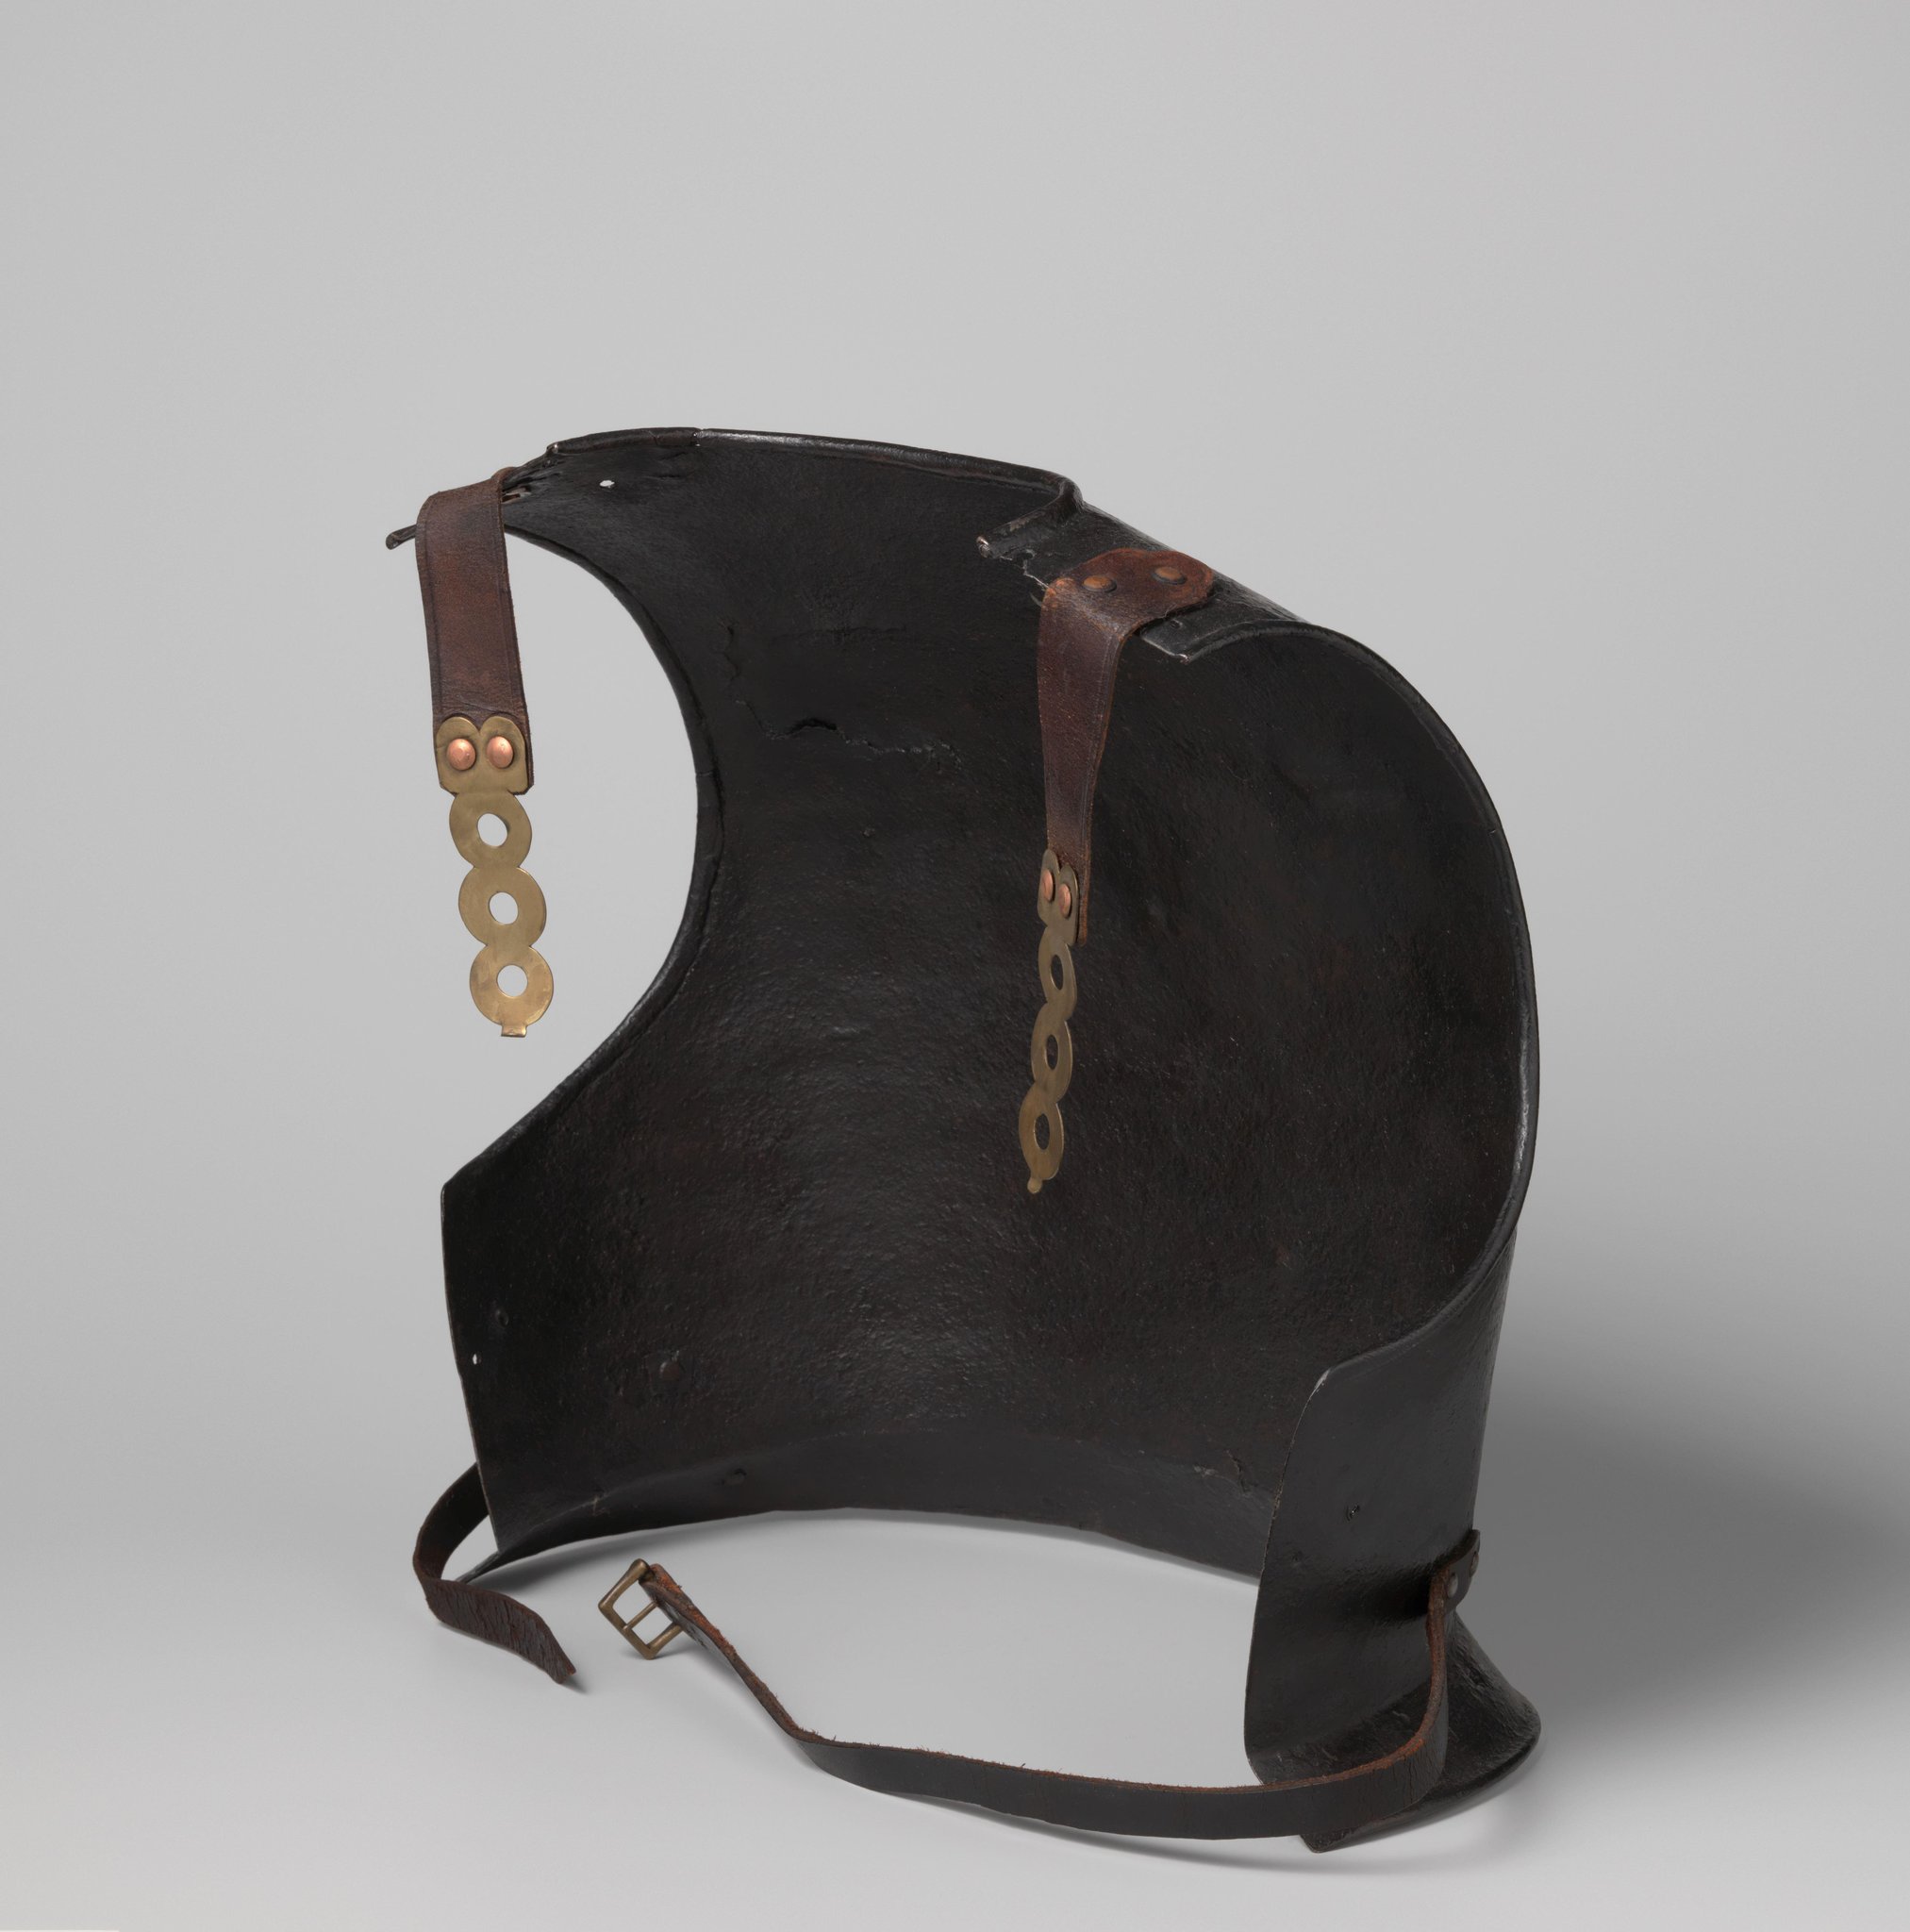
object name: backplate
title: Rugplaat van ijzeren kuras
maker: Anonymous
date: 1600-1699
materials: copper, iron, leather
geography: netherlands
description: Rugplaat, ijzer, zwart geverfd, uit één plaat gemaakt. Randen van nek- en armuitsnijdingen rondgeflenst. Aan weerzijden van de armuitsnijdingen twee aangeklonken schouderriemen, onderaan, direct boven de lendenstrook aangeklonken stoot- en gespriem van de middelriem. De driedubbele decoratielijn lopen parallel aan de randen van de rugplaat. De lendenstrook heeft aan de rechterkant een doorgeboorde pin, andere zijde ontbreekt de pin. De rand van de lendenstrook is omgflenst.